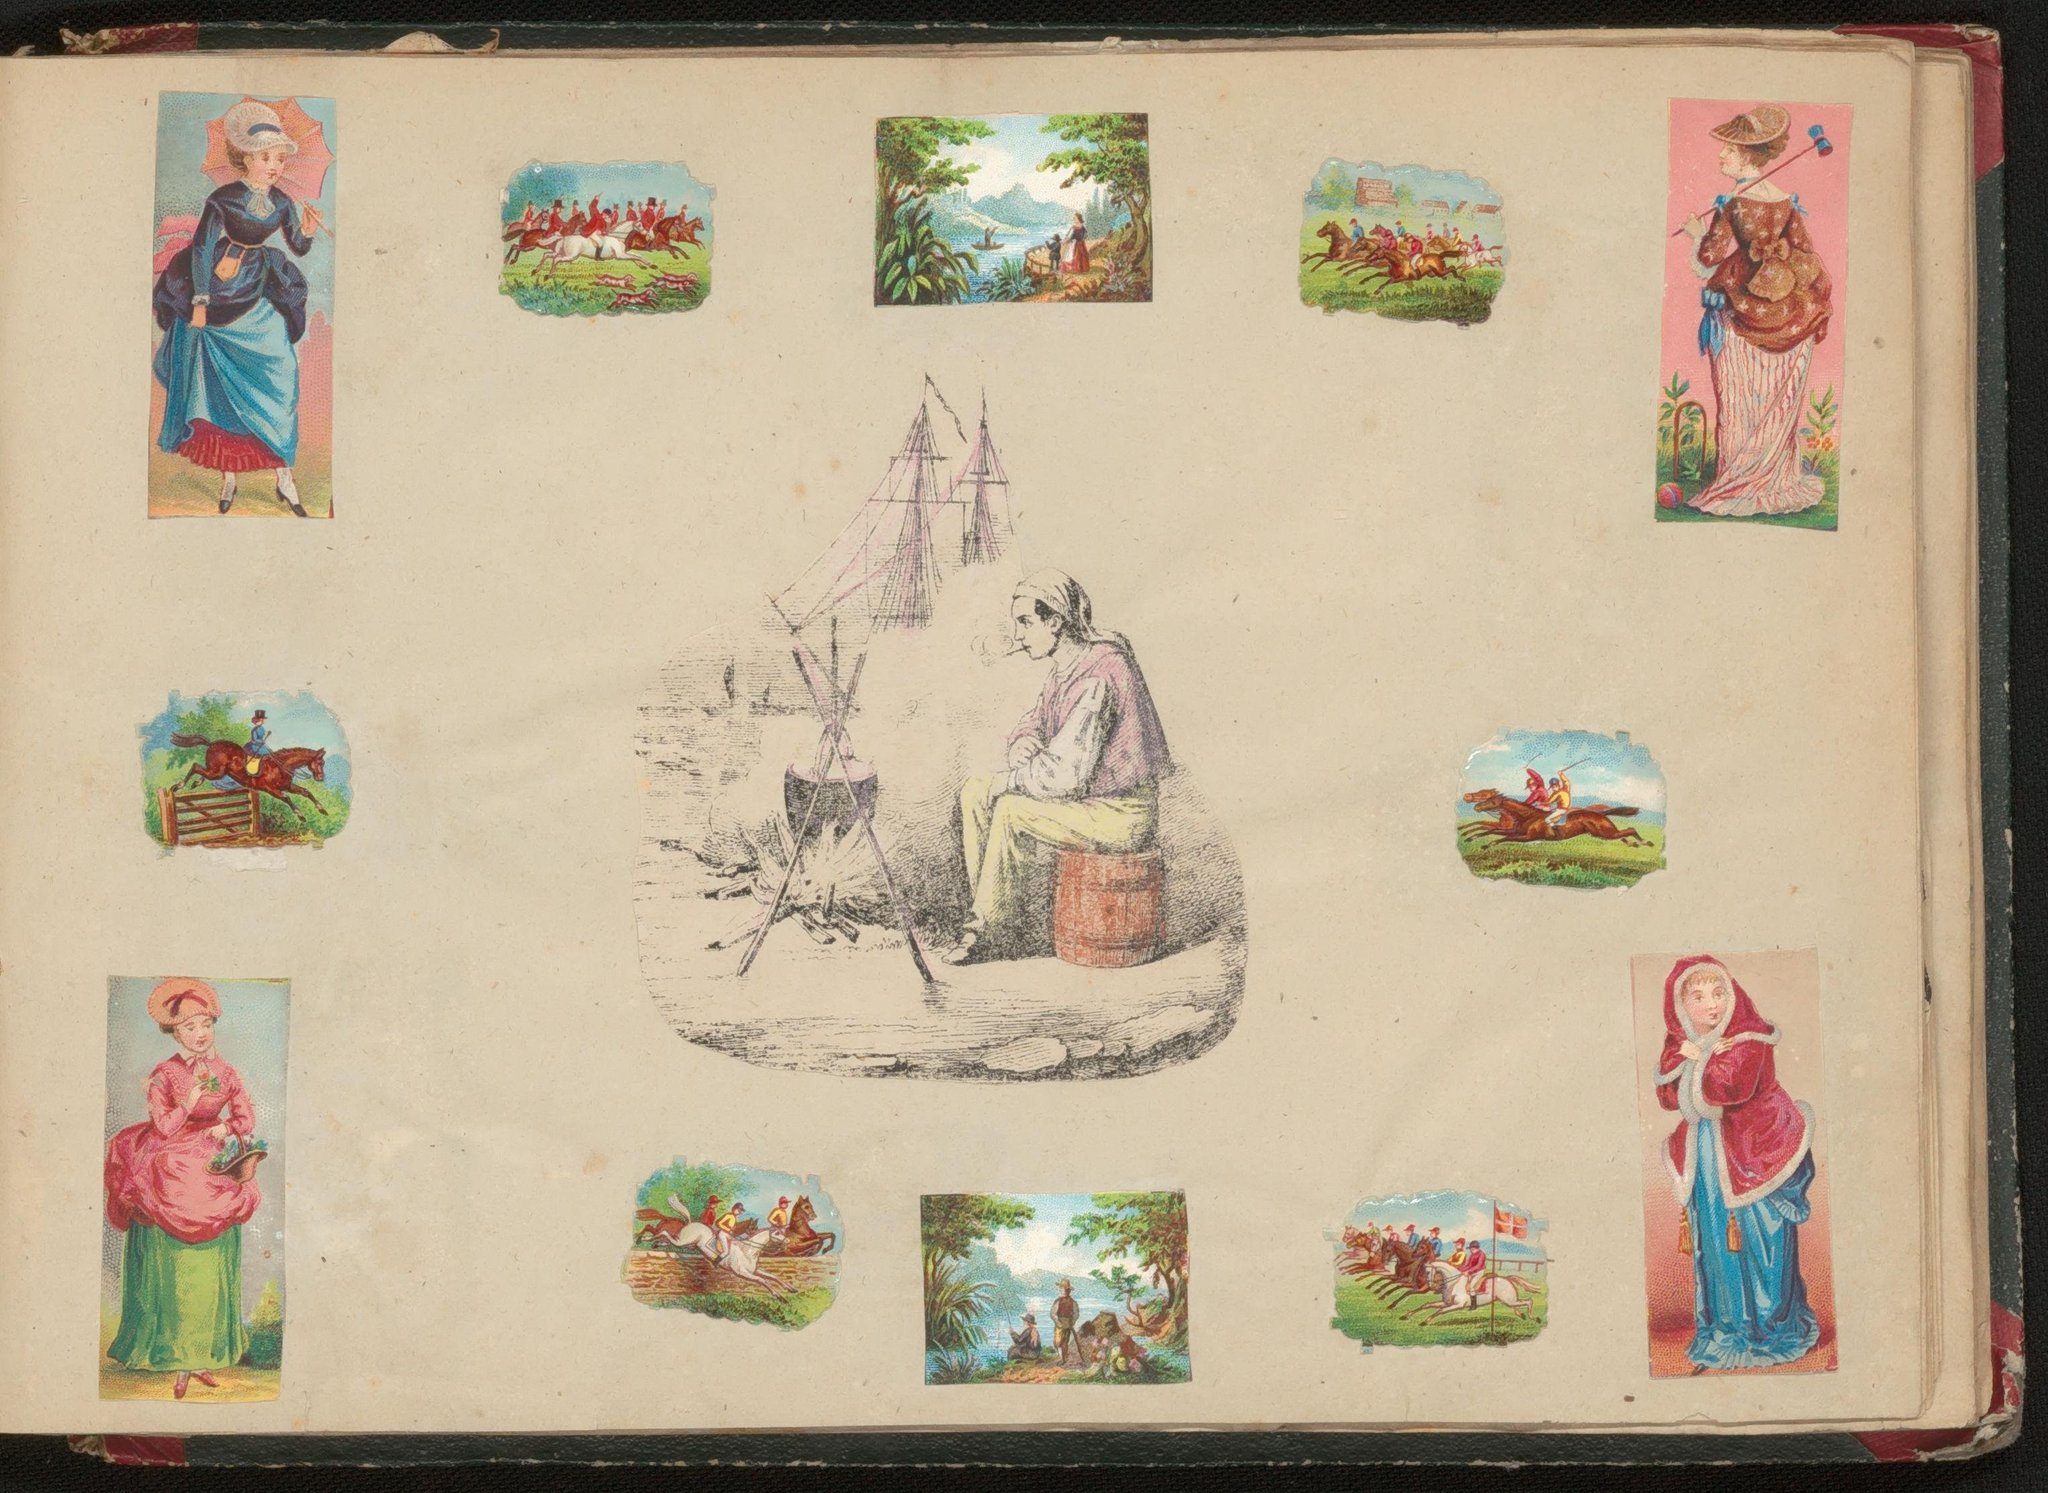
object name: album leaf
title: Albumblad met 12 plakplaatjes en een prentfragment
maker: Anonymous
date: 1880-1910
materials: paper, watercolor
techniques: chromolithography, hand coloring, lithograph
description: Albumblad met 12 plakplaatjes en een ingeplakte uitgeknipte fragment van een prent van een zittende zeeman. Onderdeel van het plakboek met 38 bladen gevuld met plakplaatjes, poesieplaatjes en uitgeknipte en ingeplakte fragmenten van prenten. Onderwerpsrubrieken binnen de Atlas Zeden en Gewoonten: Schoone kunsten, Varia.